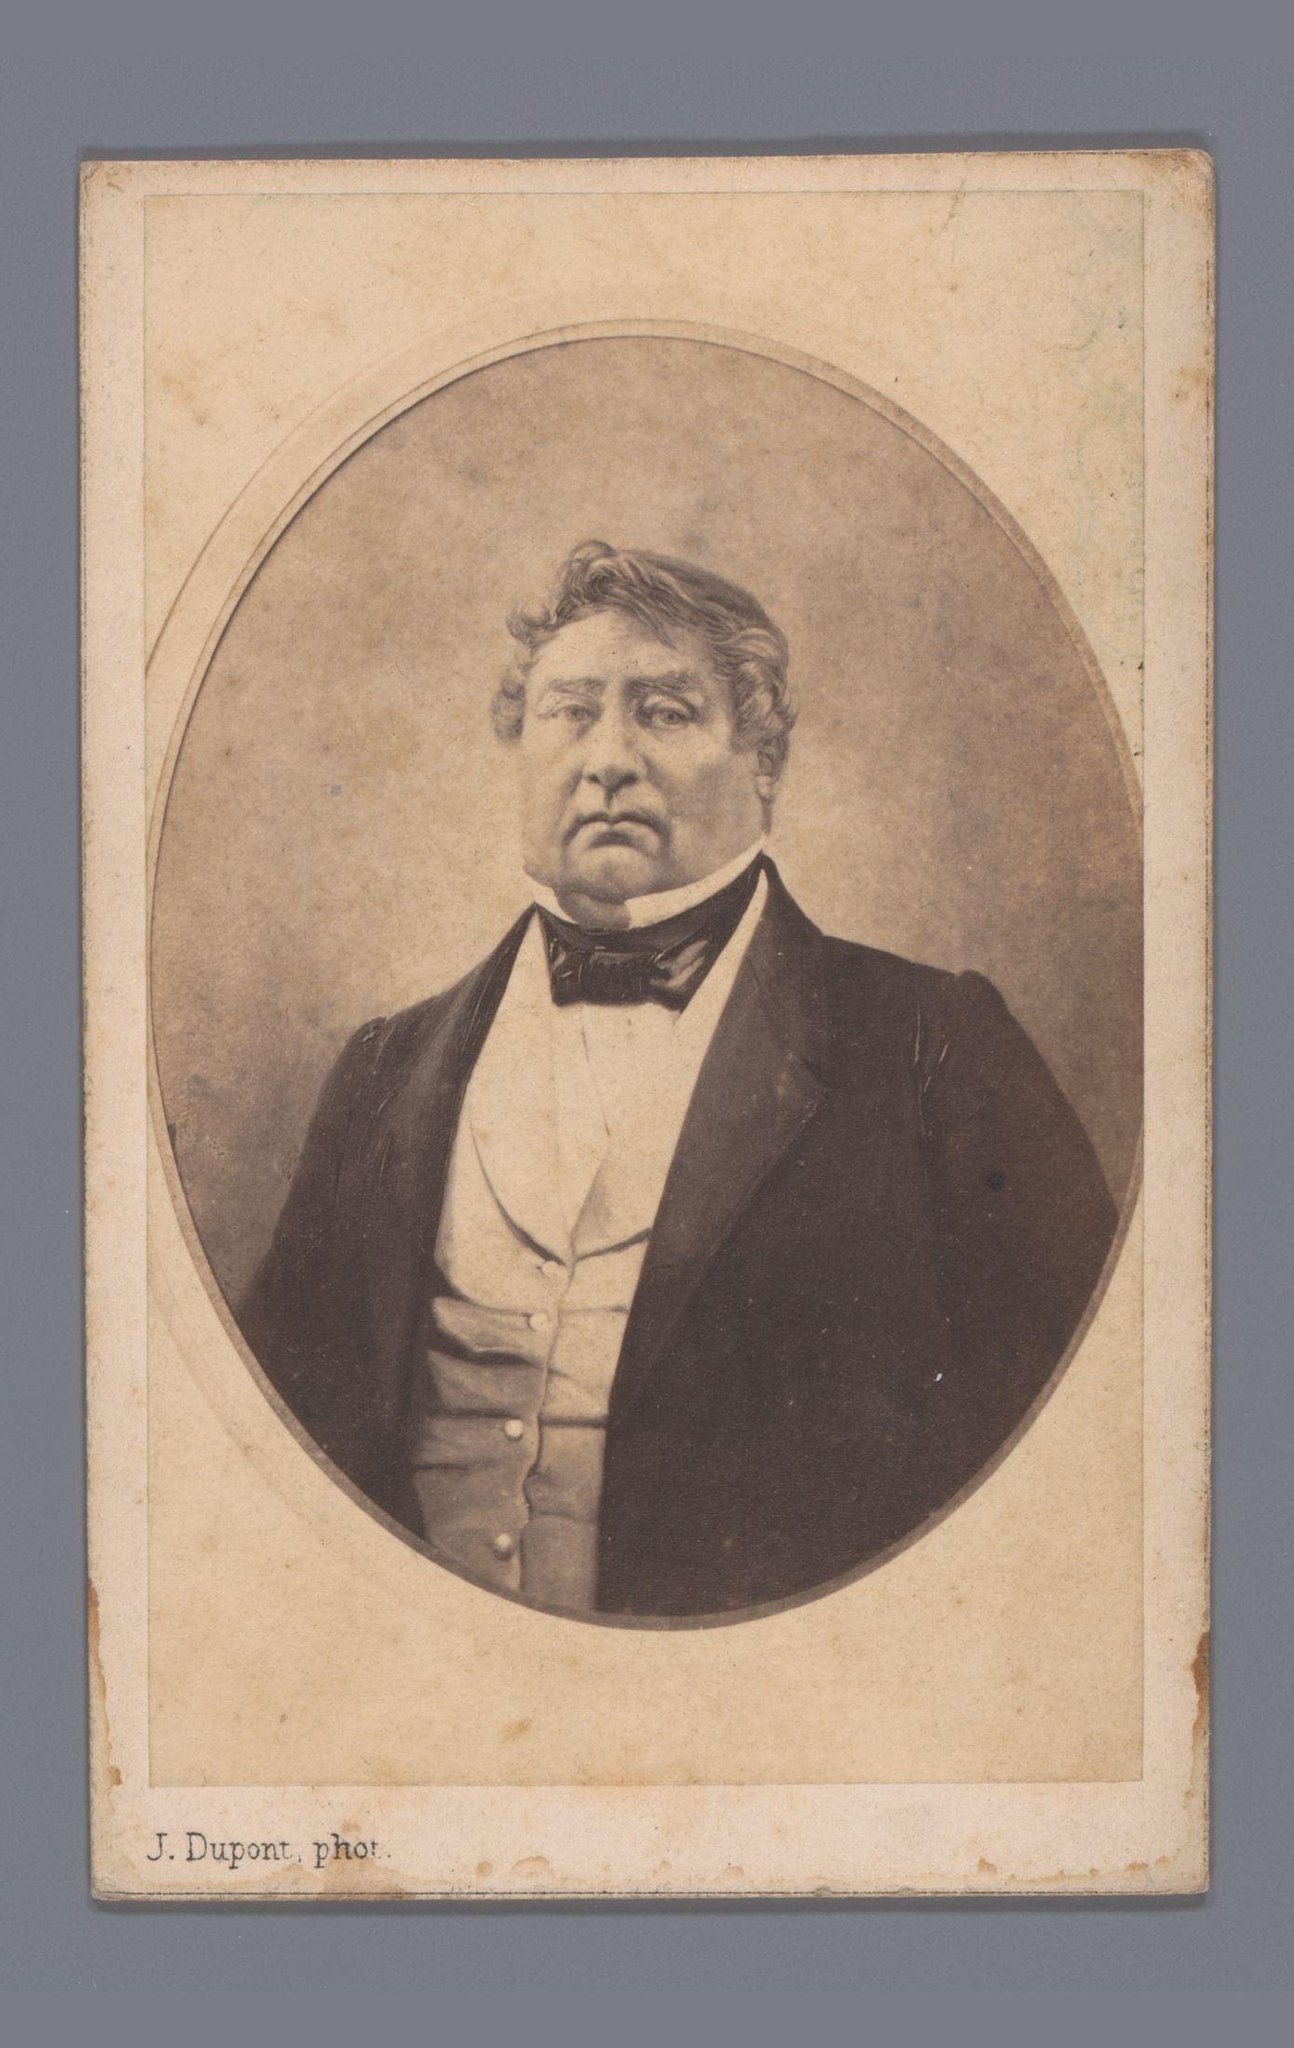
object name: photograph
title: Portret van een onbekende man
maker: joseph dupont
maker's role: fotograaf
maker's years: 1818-1901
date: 1859-1873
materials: cardboard, paper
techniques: albumen print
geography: antwerp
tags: adult man, anonymous historical person portrayed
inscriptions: address: ‘Place de Meir, 32/ ANVERS.’